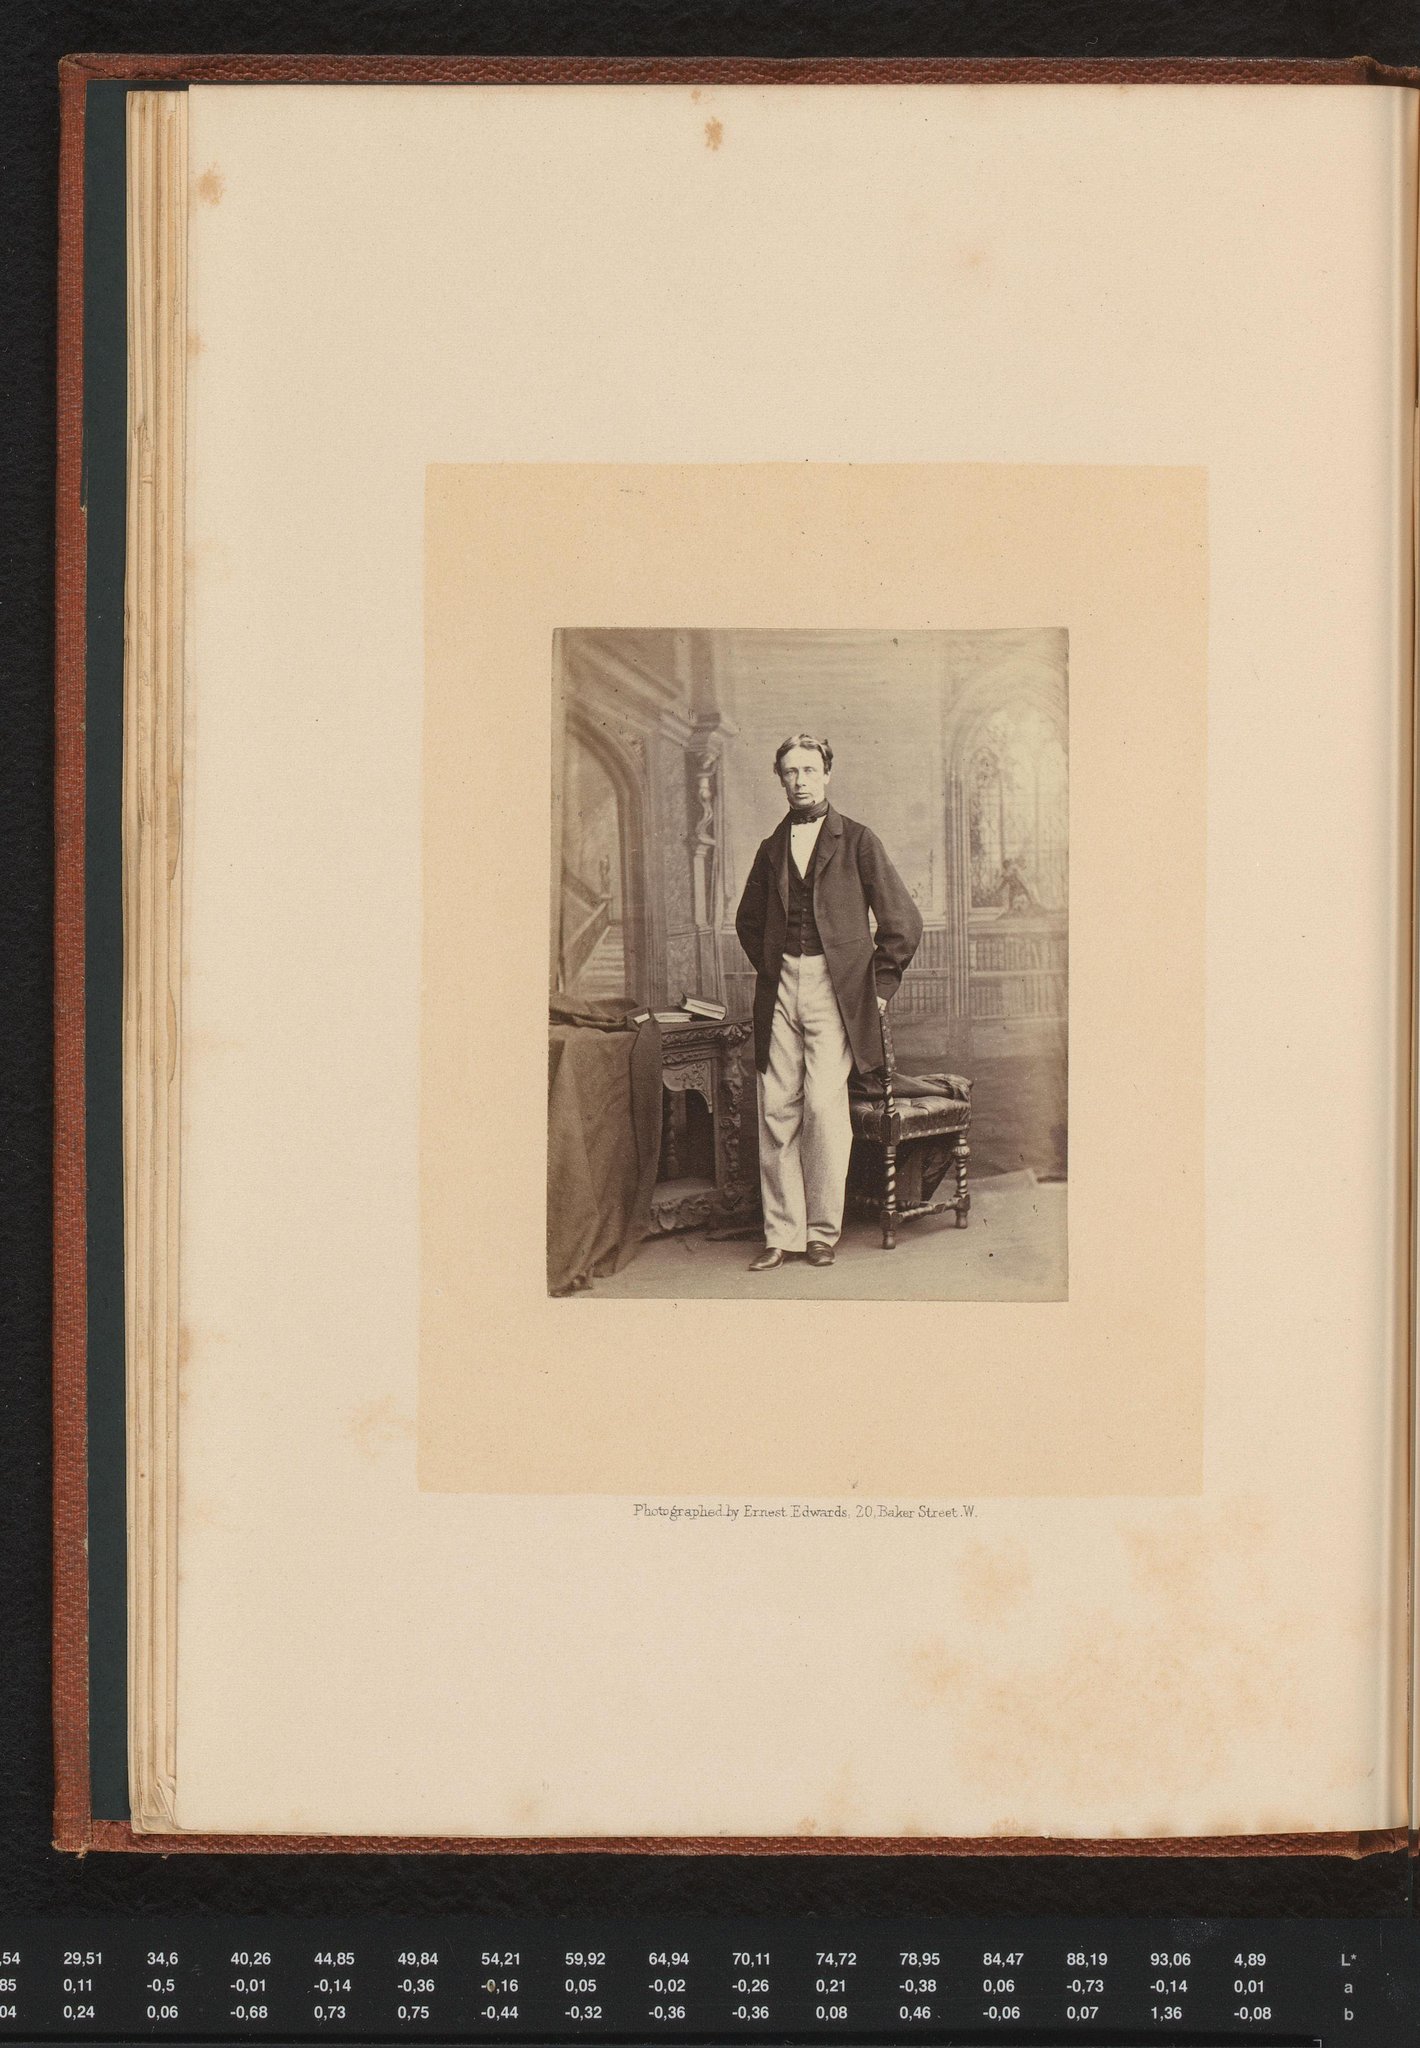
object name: photograph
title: Portret van de schrijver Coventry Patmore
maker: ernest edwards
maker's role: fotograaf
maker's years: 1837-1903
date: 1861-1866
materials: paper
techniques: albumen print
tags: portrait of a writer